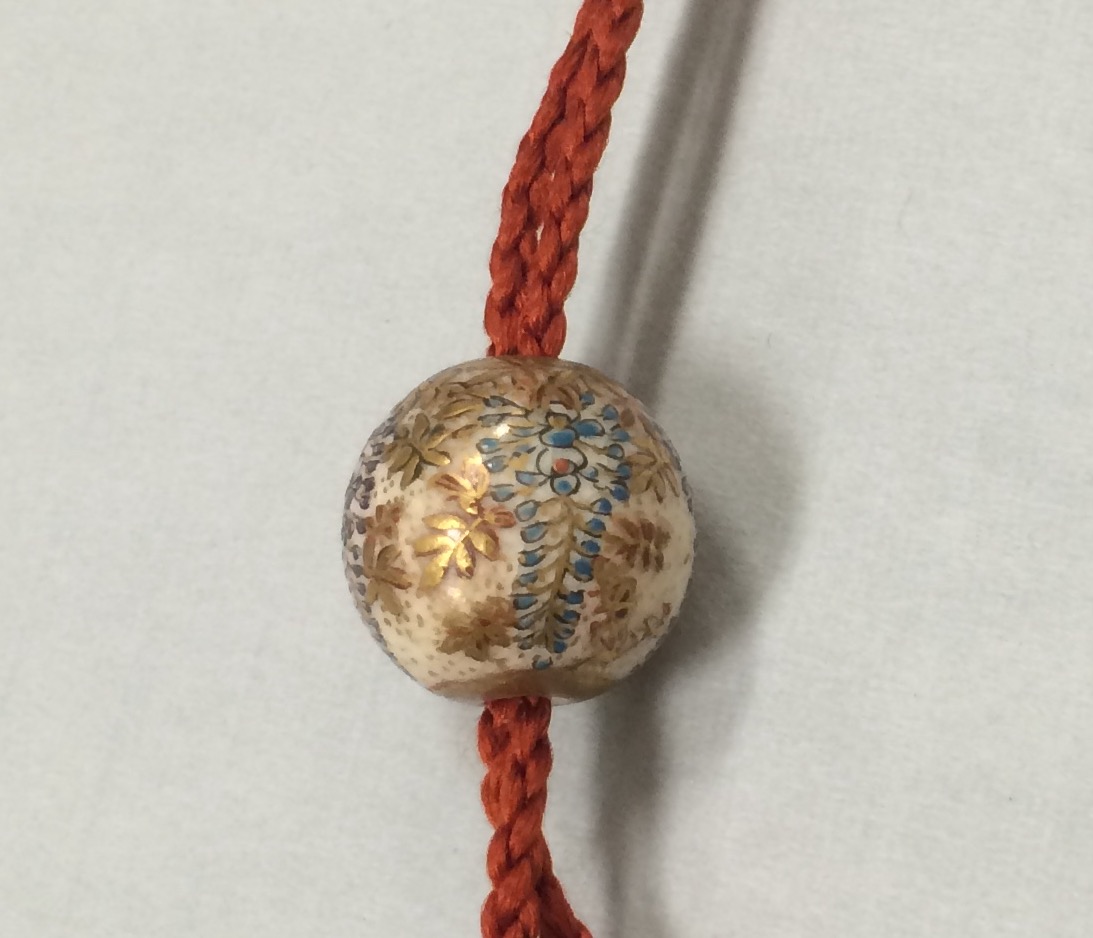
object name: ojime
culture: japanese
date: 1701-1800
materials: enamel, faience, glaze, gold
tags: leaves